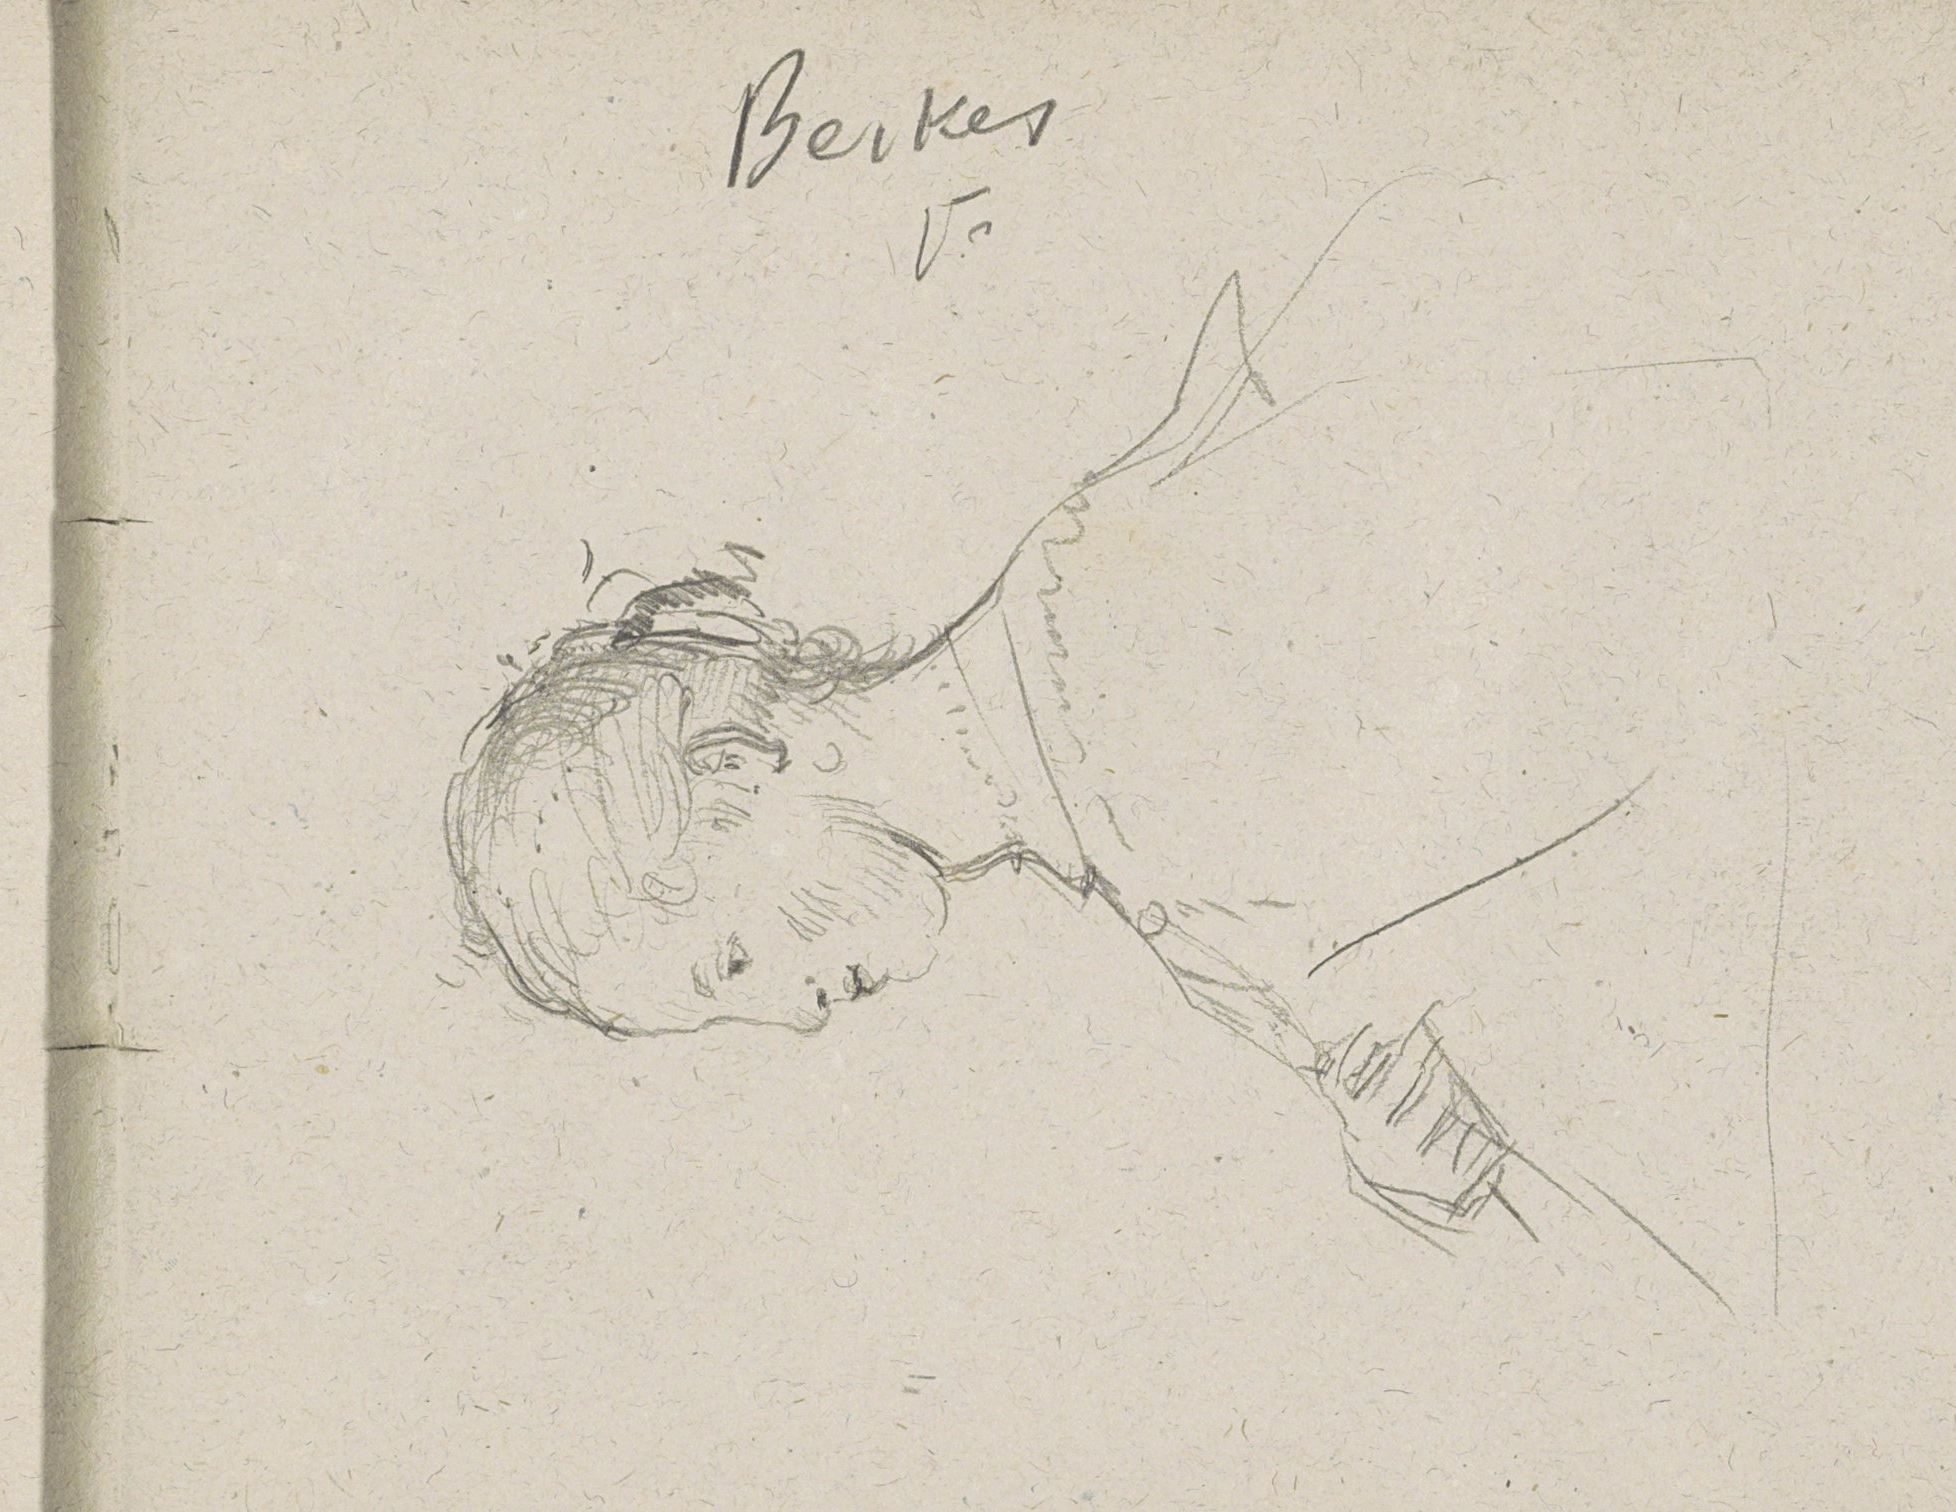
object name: sketchbook leaf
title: Portret van een onbekende vrouw, in profiel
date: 1919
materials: paper, pencil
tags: anonymous historical person portrayed alone - bb - woman, picture, painting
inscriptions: annotation: ‘Berkes’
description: Mogelijk naar een schilderij uit de collectie van een museum in Kopenhagen of Stockholm. Pagina 4 uit schetsboek XXXV met 36 pagina's.